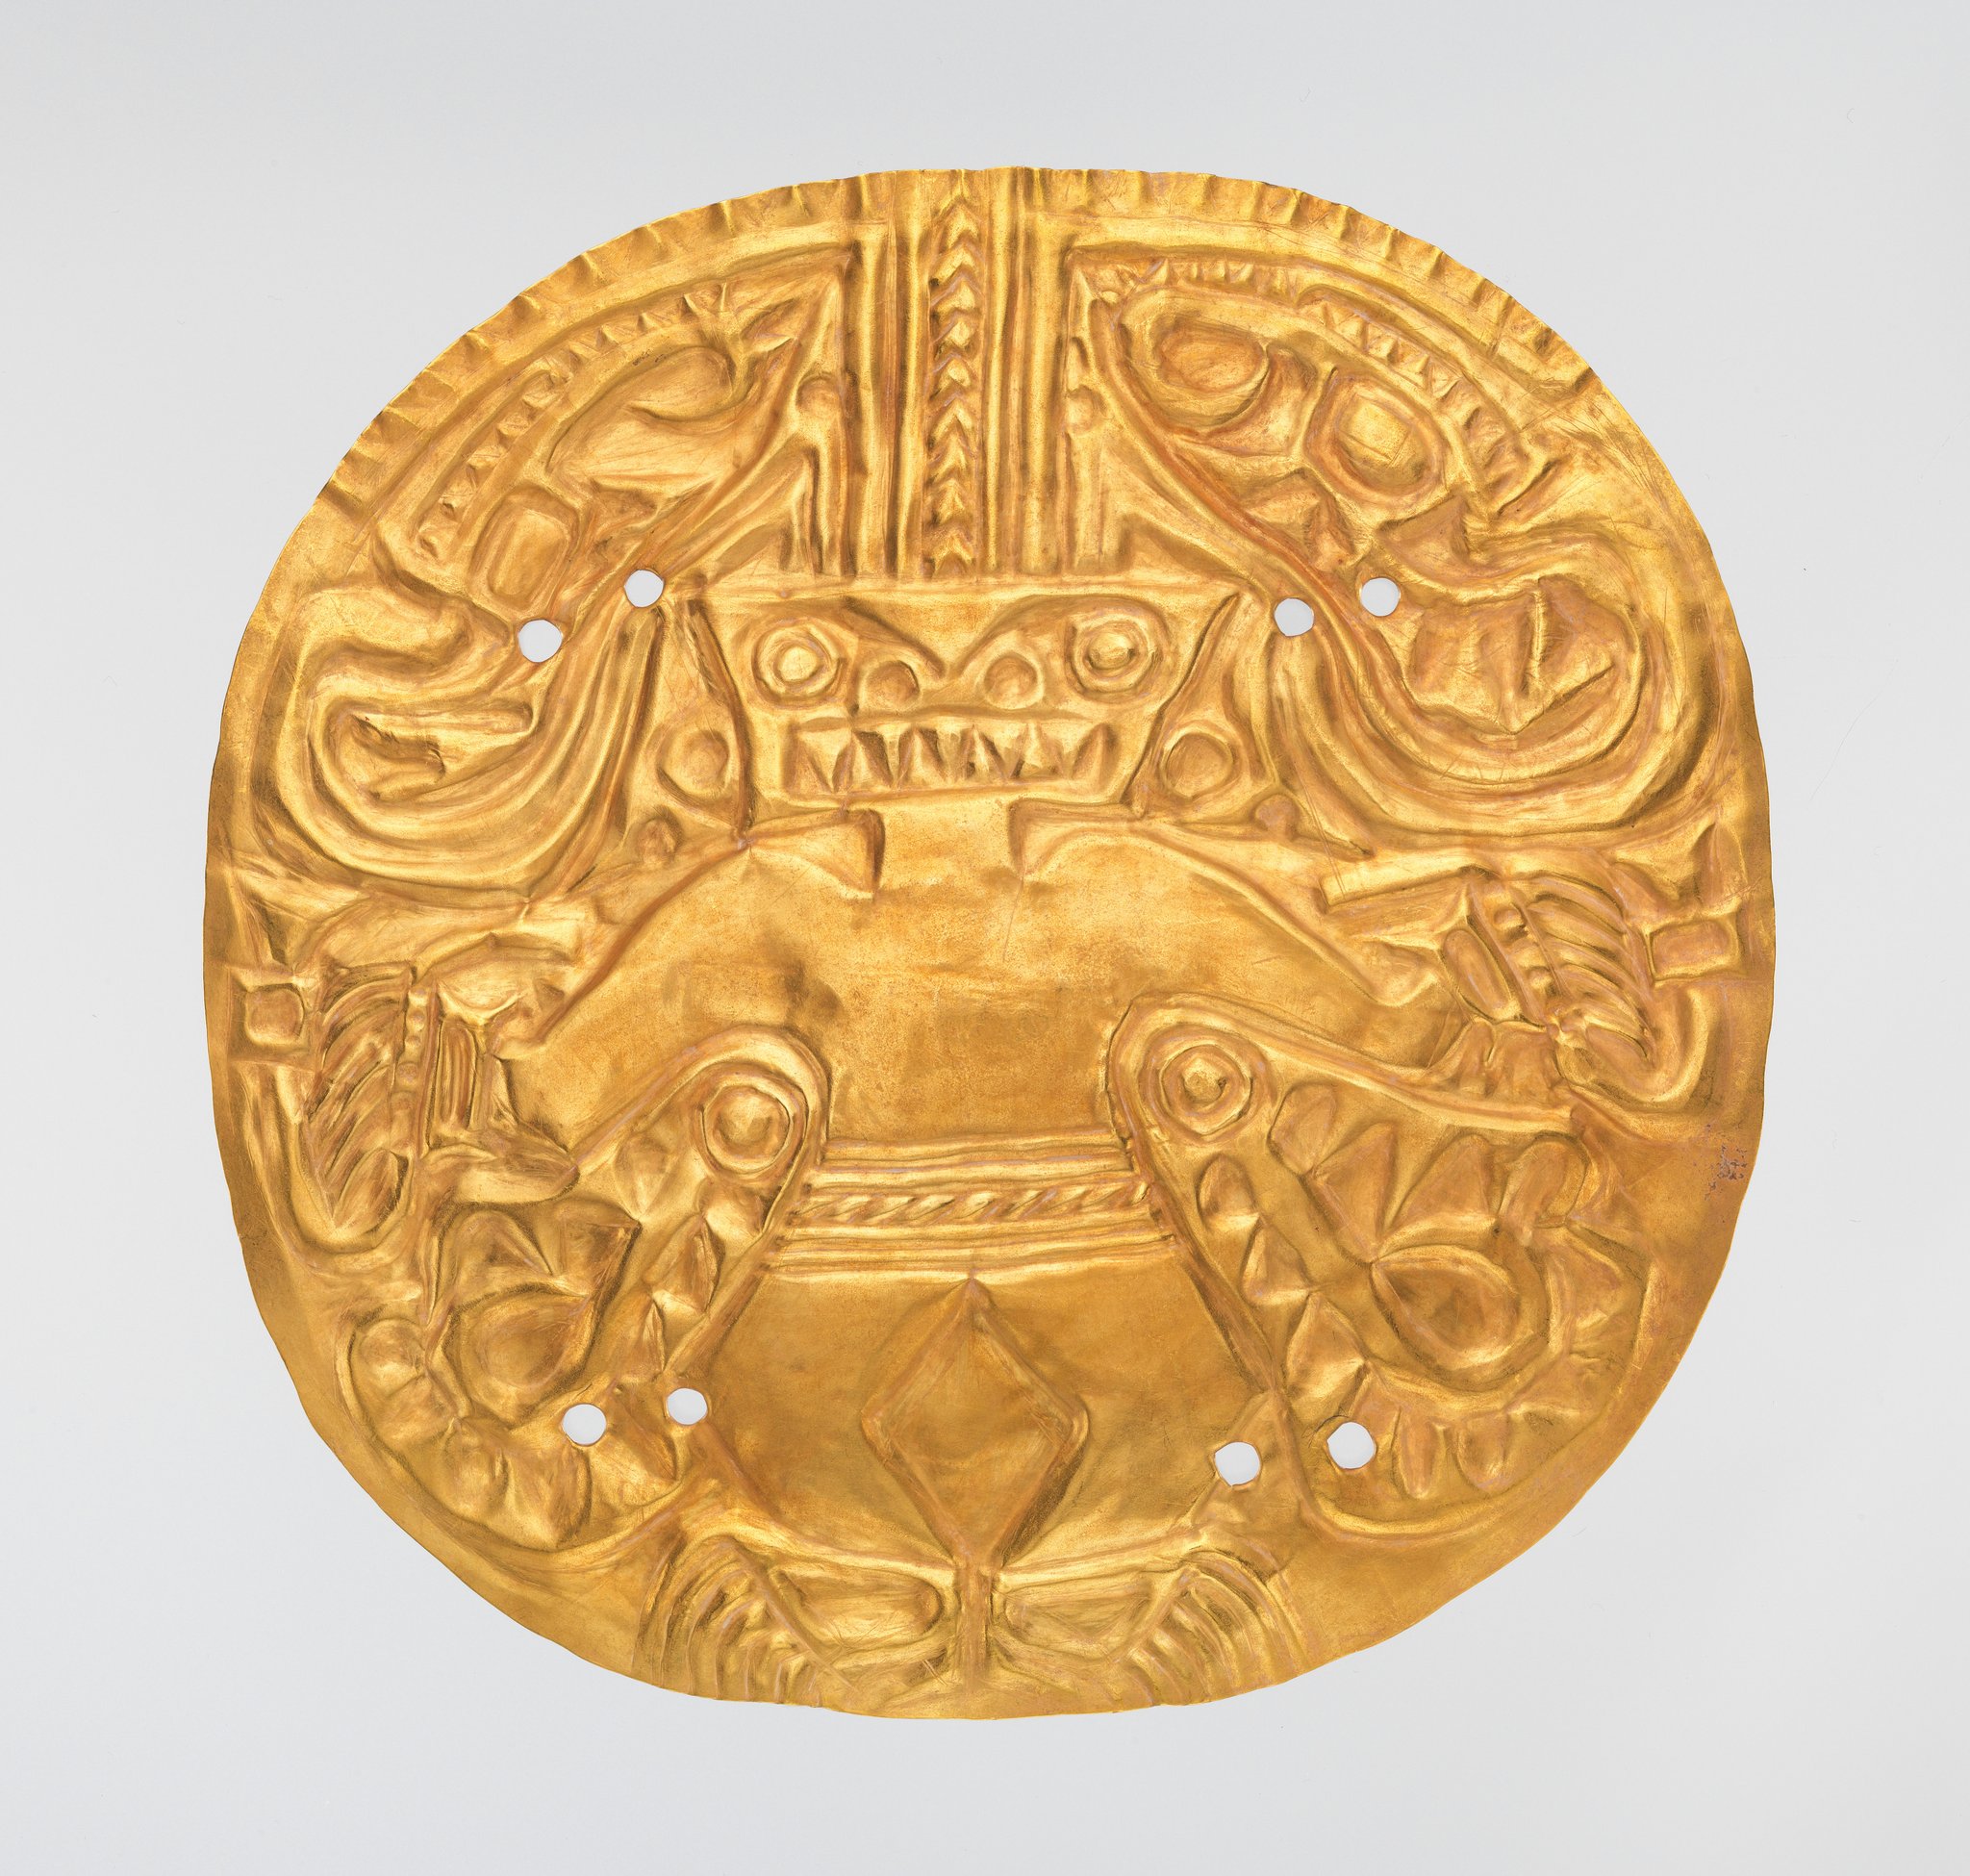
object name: disk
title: Plaque with Masked Figure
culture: coclé, macaracas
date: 701-1200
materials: gold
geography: panama